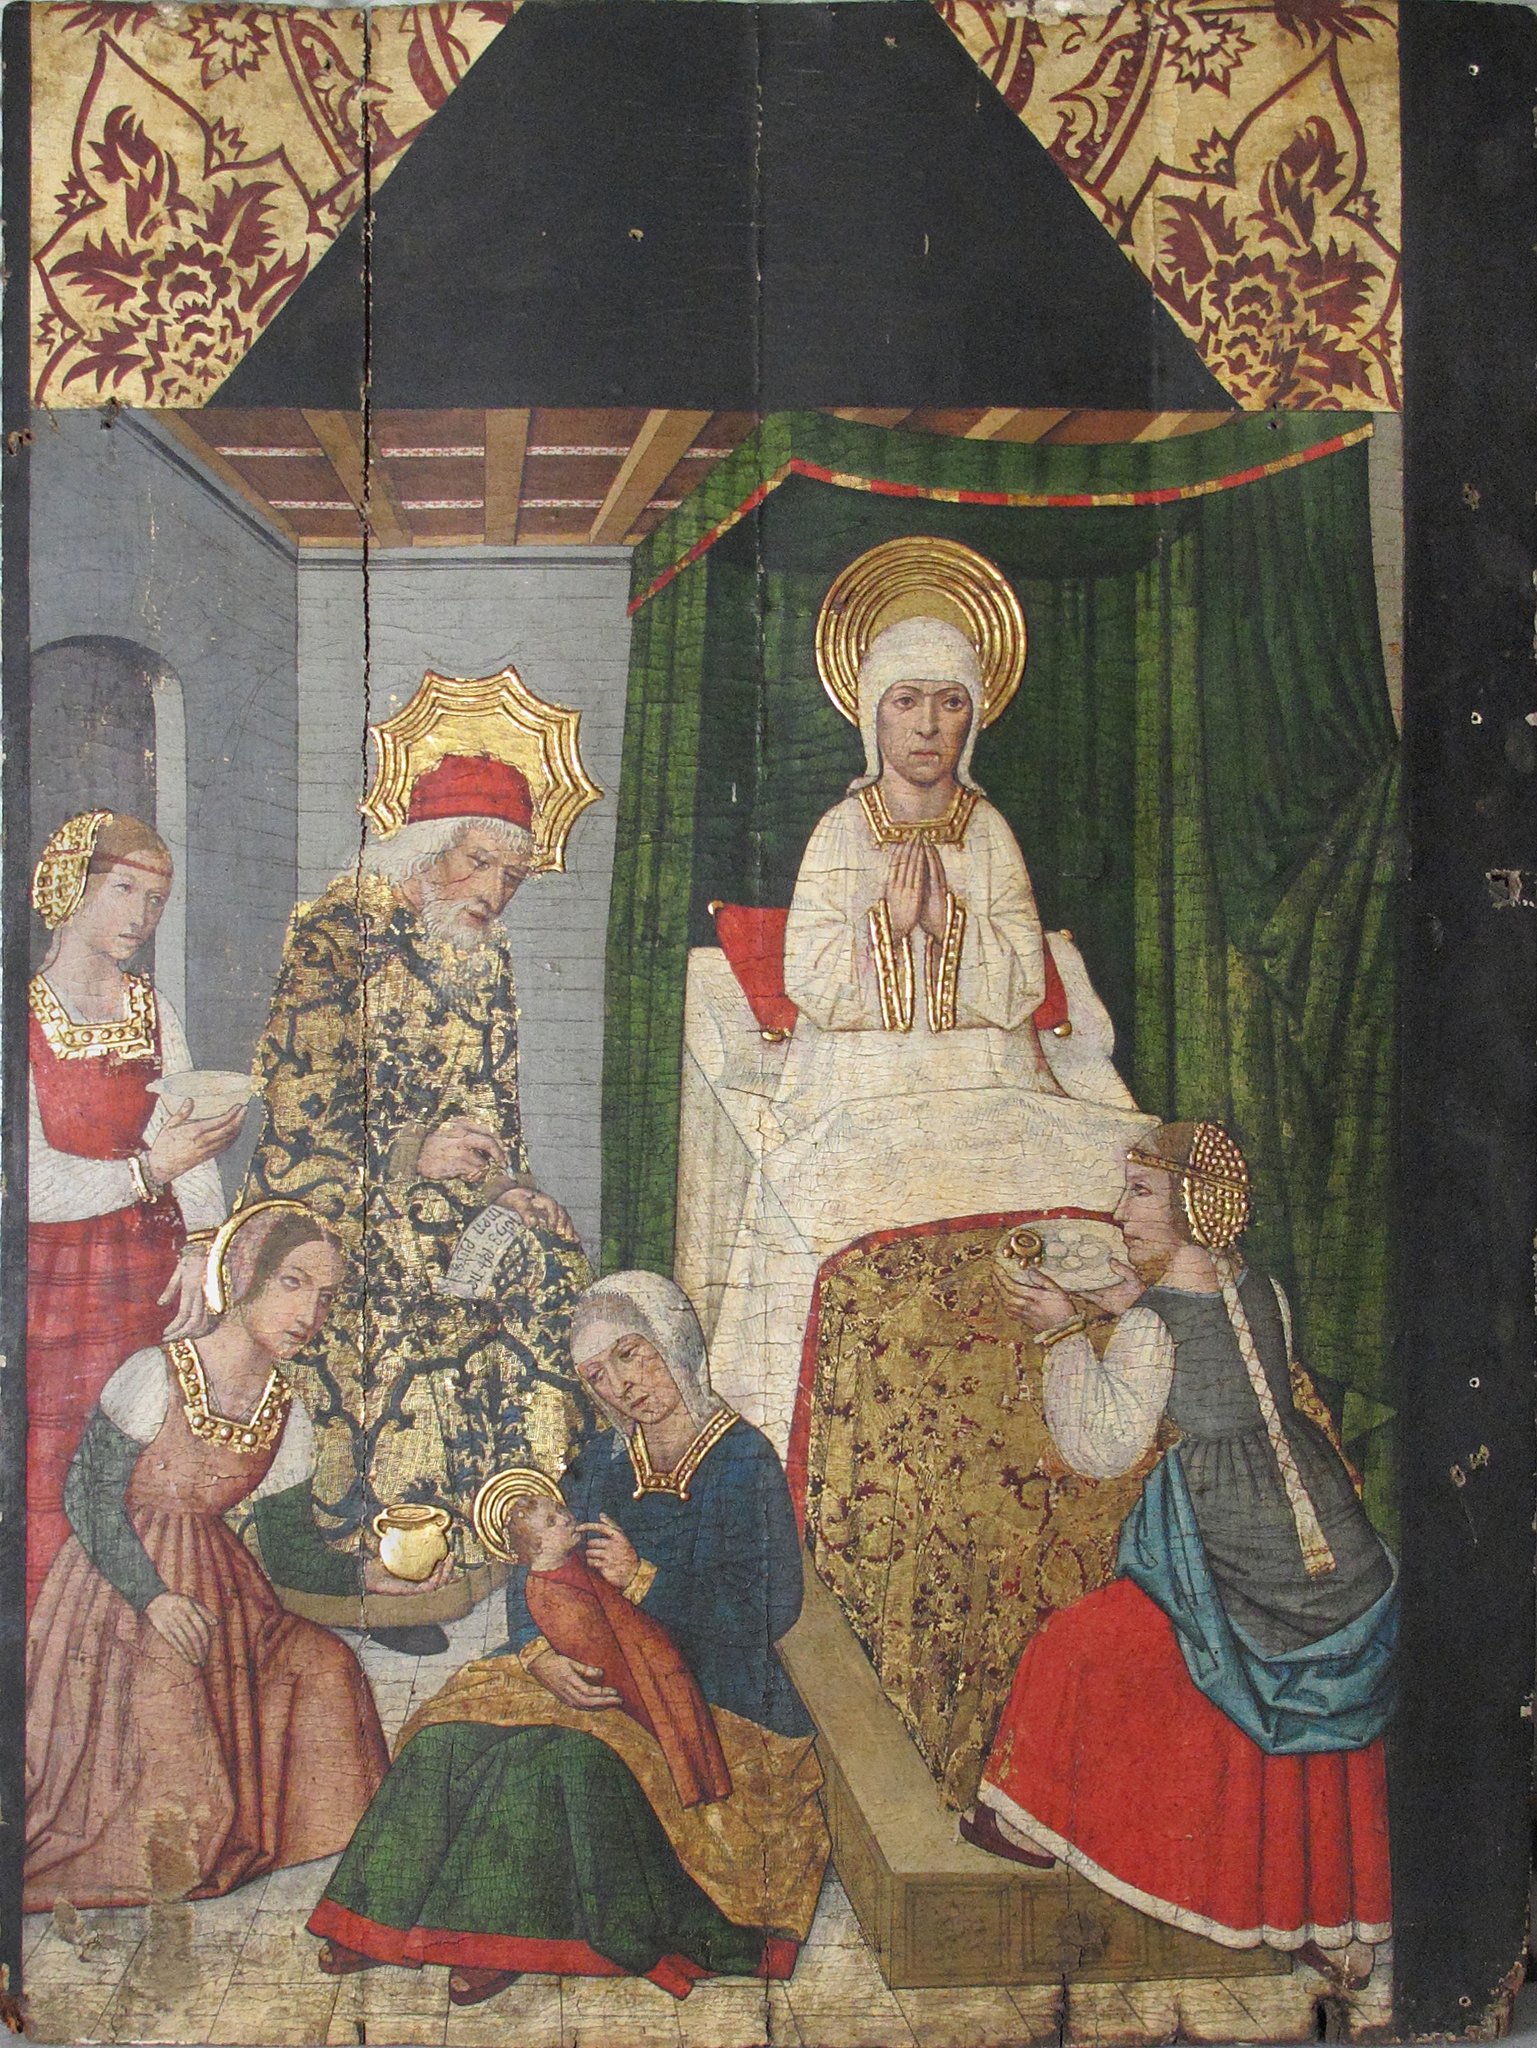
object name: painting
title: Panel with the Birth of St. John the Baptist from Retable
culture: spanish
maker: domingo ram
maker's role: artist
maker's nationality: spanish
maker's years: 1464-1507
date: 1401-1500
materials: gold leaf, paint, wood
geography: spain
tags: men,women,saint john the baptist,birth,beds